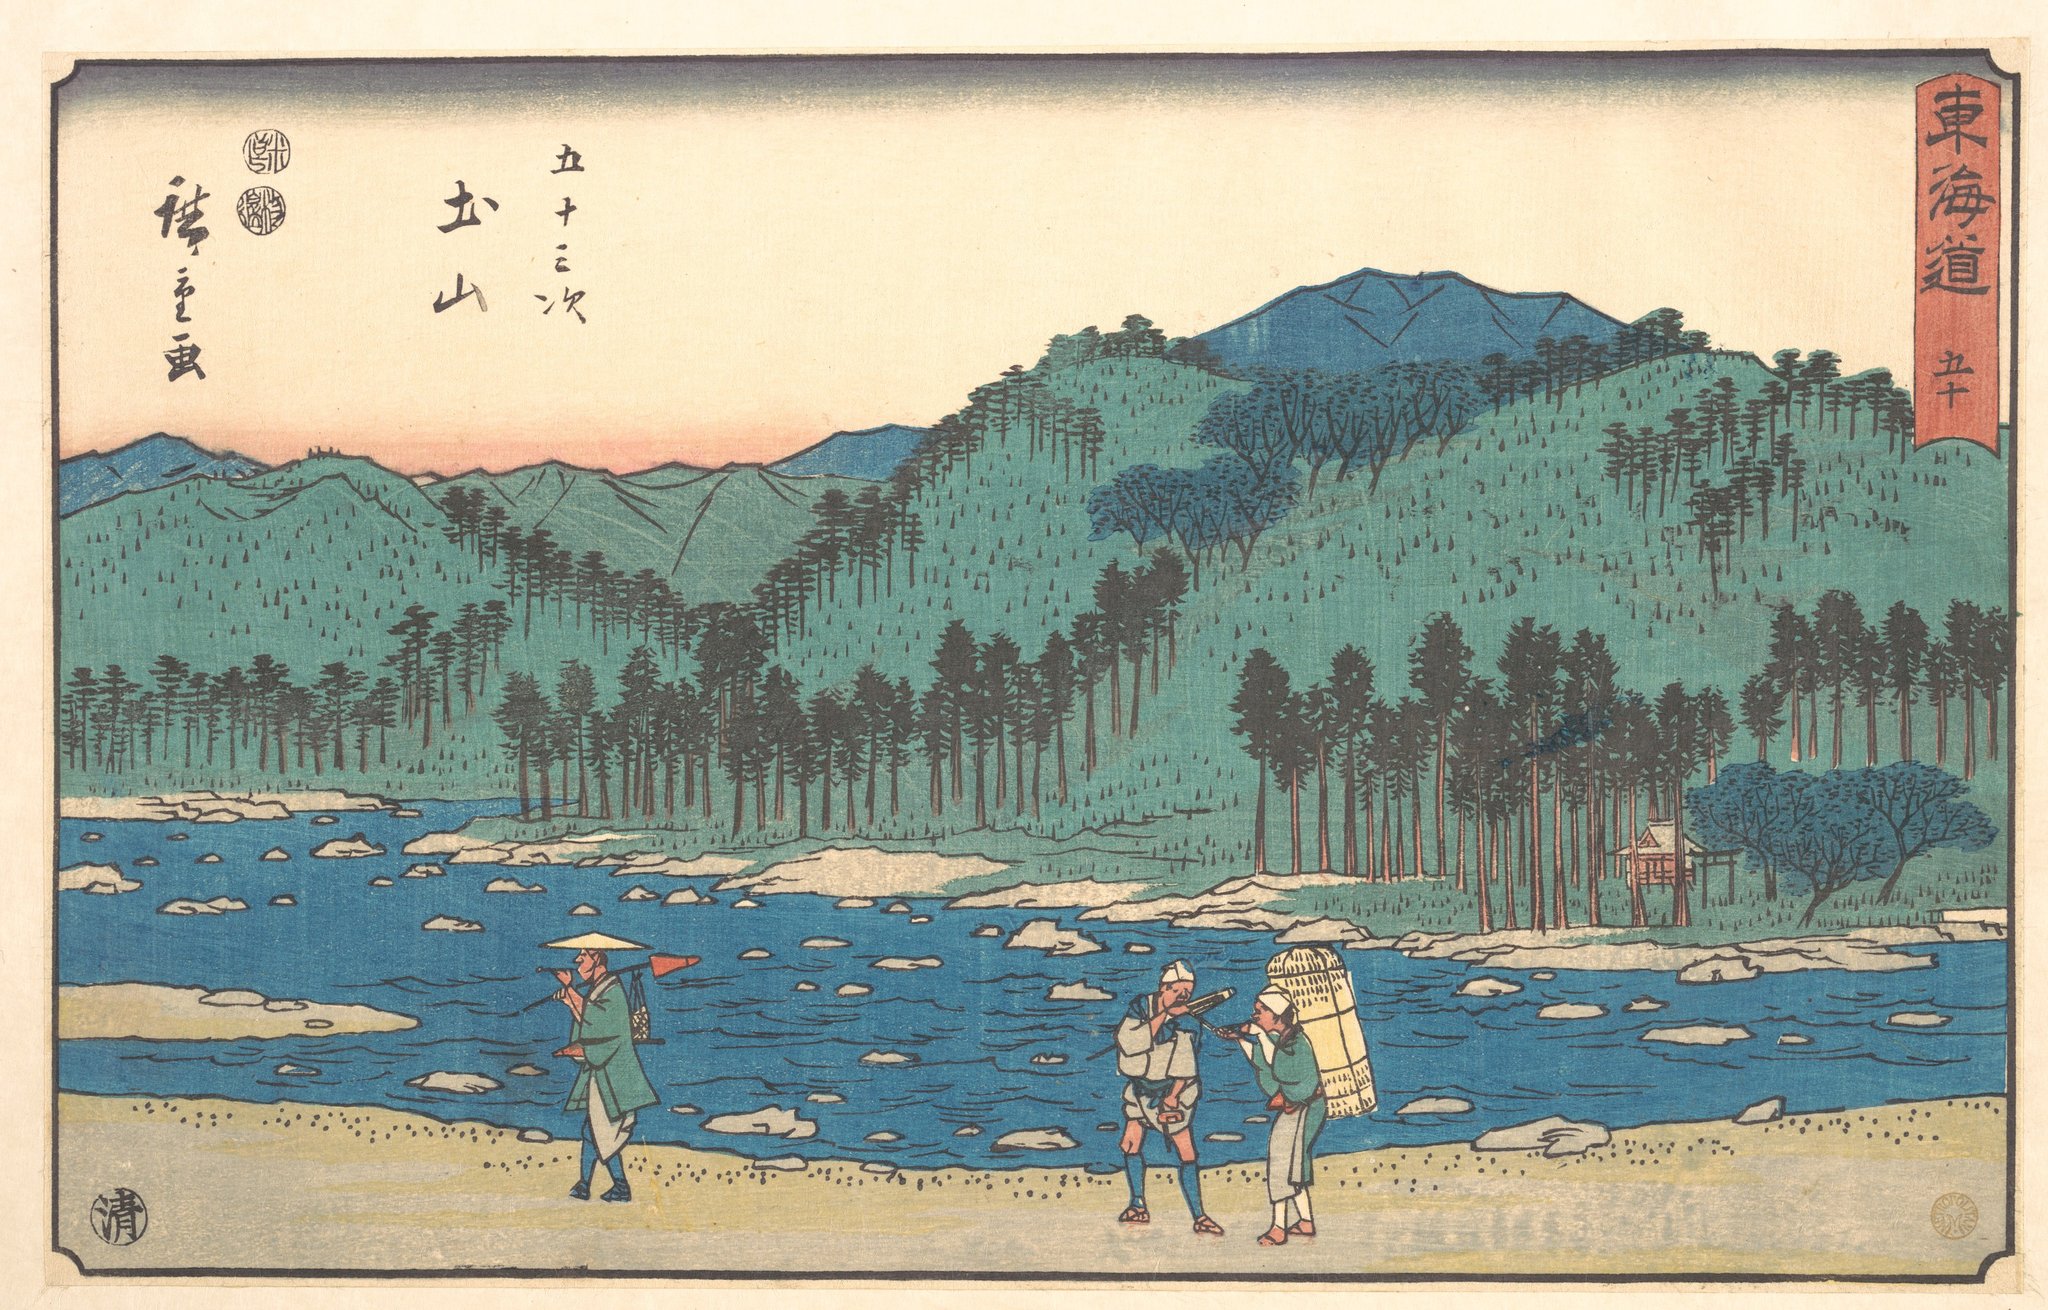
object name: print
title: Tsuchiyama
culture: japanese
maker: utagawa hiroshige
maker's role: artist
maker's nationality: japanese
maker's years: 1797-1858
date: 1840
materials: ink, paper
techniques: woodblock print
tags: men,rivers,mountains